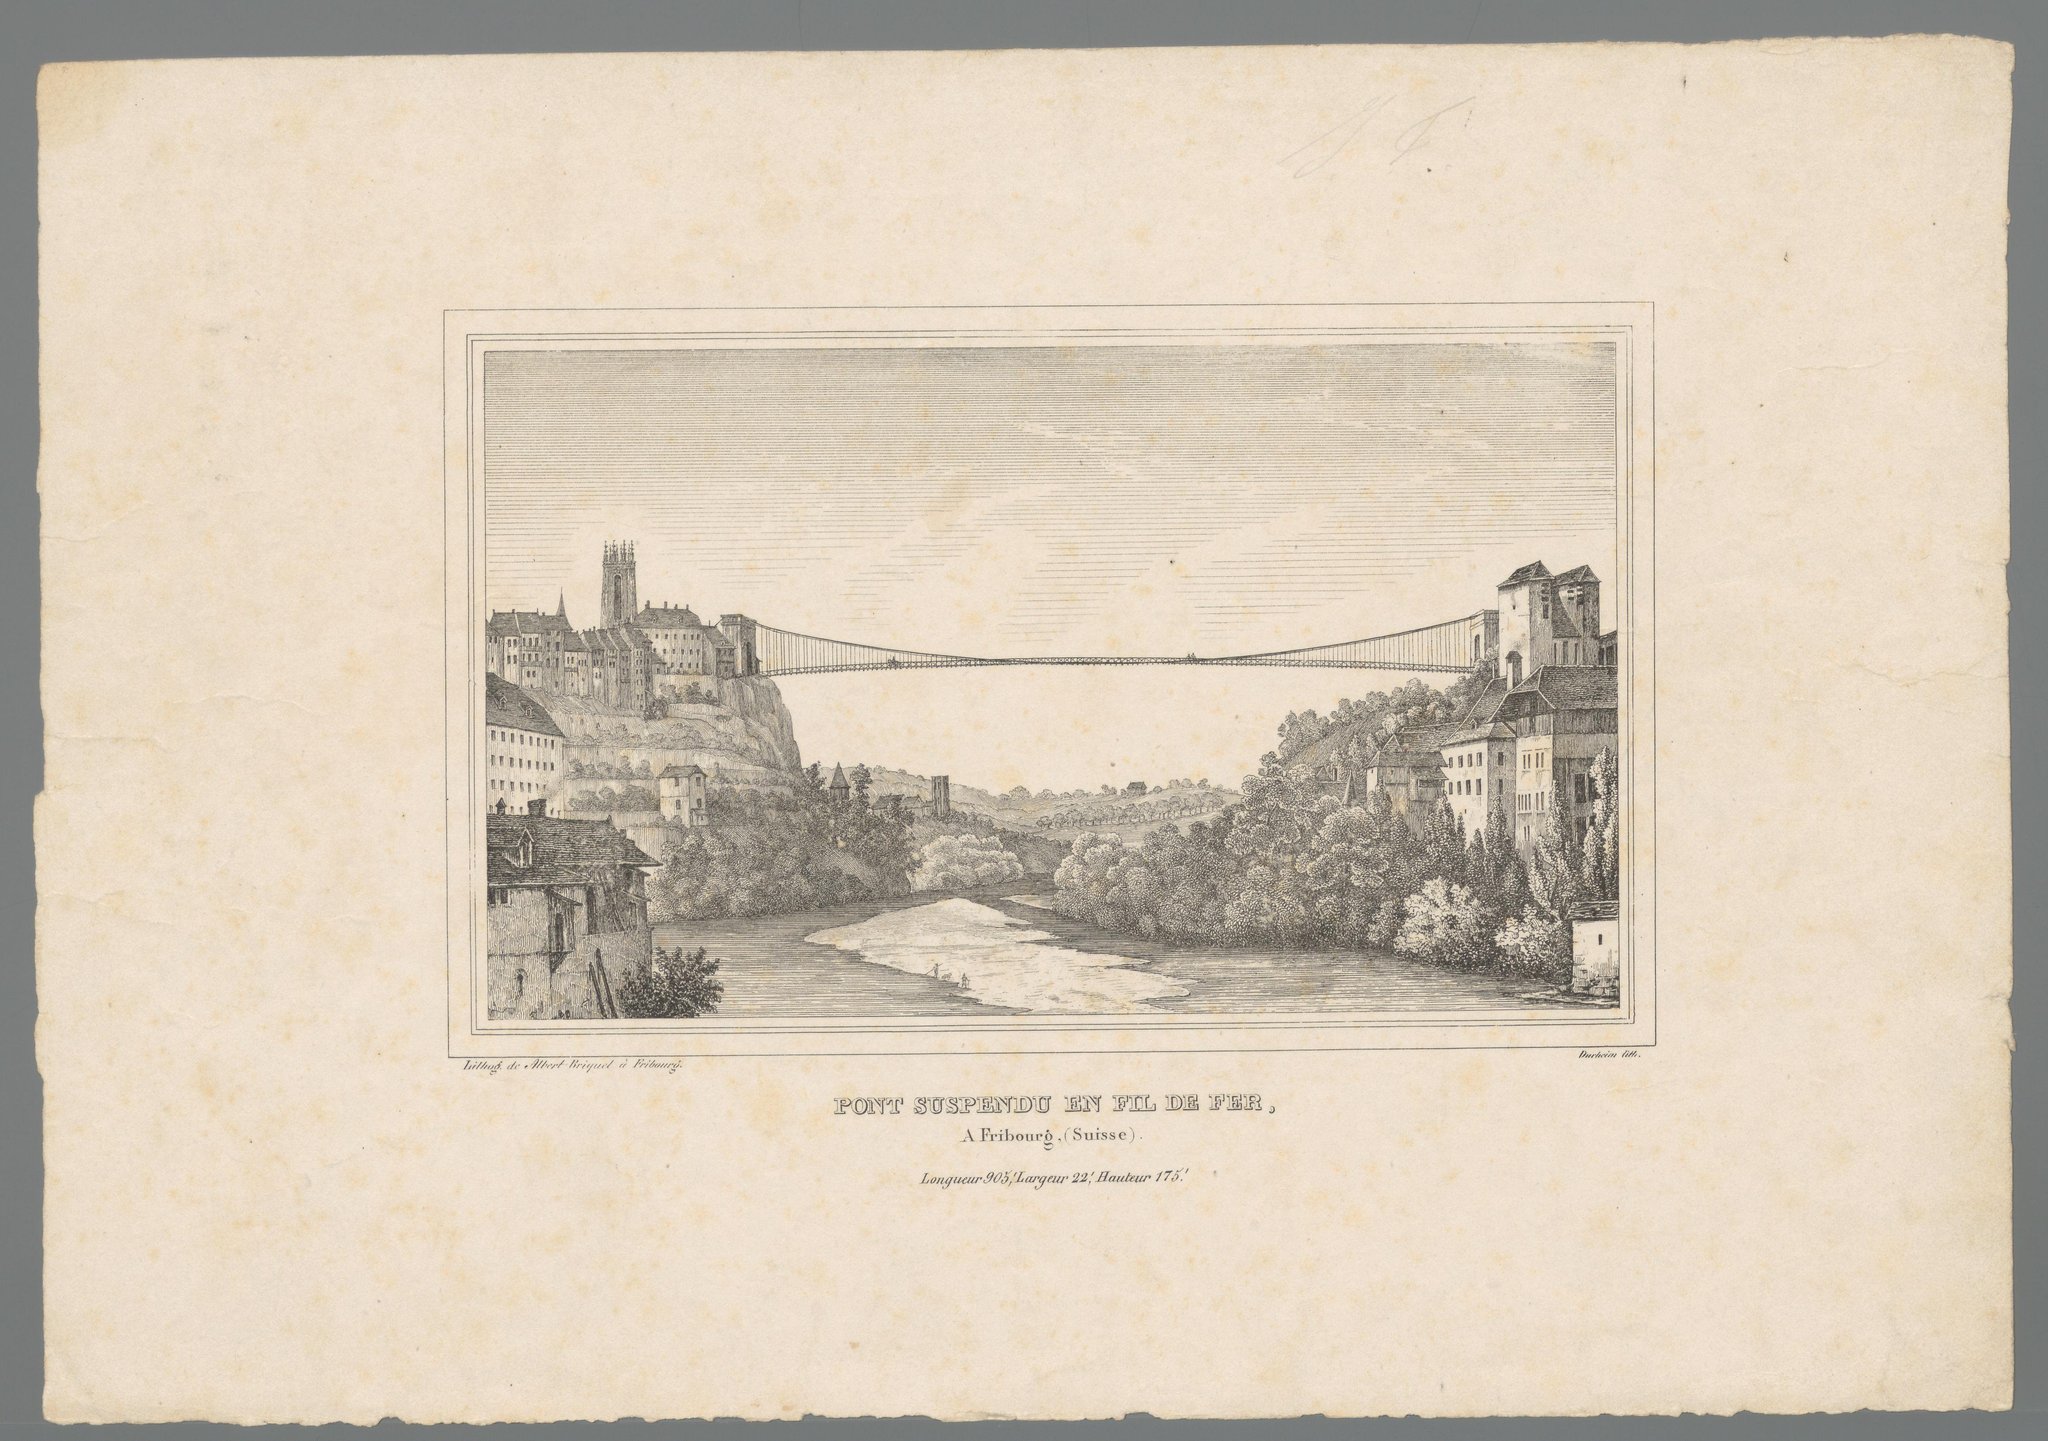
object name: print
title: Pont suspendu en fil de fer, A Fribourg (Suisse)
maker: albert briquet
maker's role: printer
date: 1821-1895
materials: paper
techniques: lithograph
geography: fribourg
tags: bridge, city-view, and landscape with man-made constructions (+ city(-scape) with figures, staffage)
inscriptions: inscription: ‘J[F]. Binkh[rn I]’, collector's mark: Lugt 2228